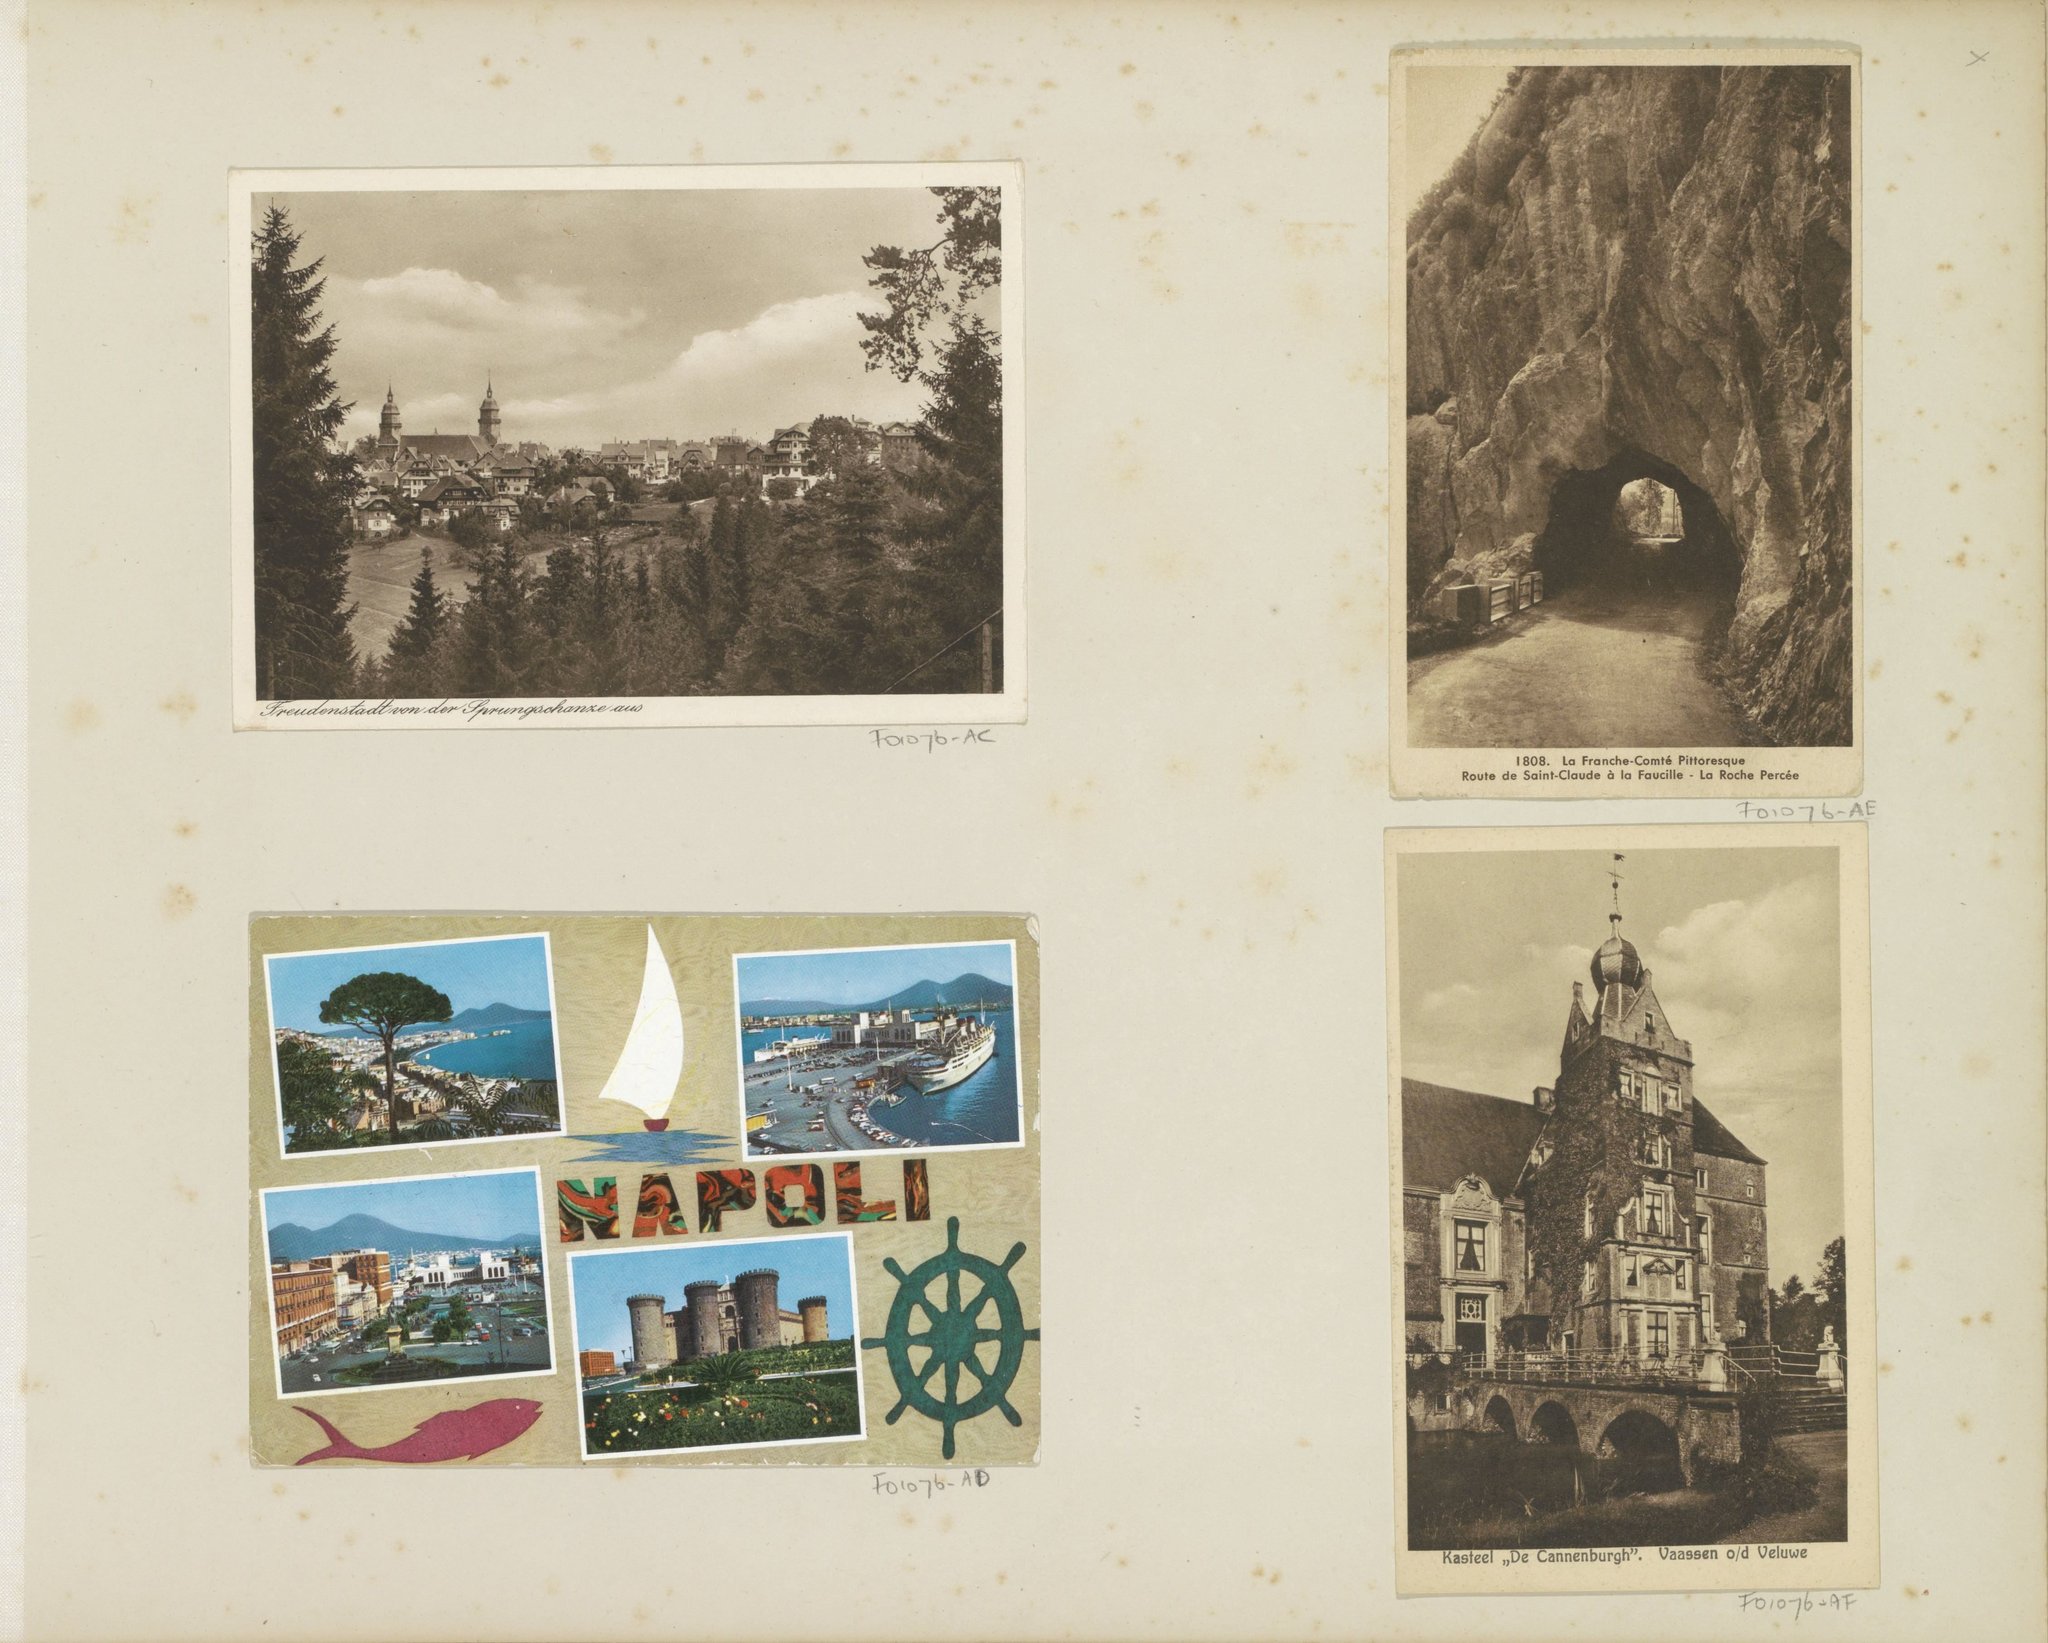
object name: photograph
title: Kasteel 'De Cannenburgh'. Vaassen o/d Veluwe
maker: Anonymous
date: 1900-1940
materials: cardboard, paper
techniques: photograph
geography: vaassen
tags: castle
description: Onderdeel van Album met foto's van spoorwegen in Nederlands-Indië en prentbriefkaarten.